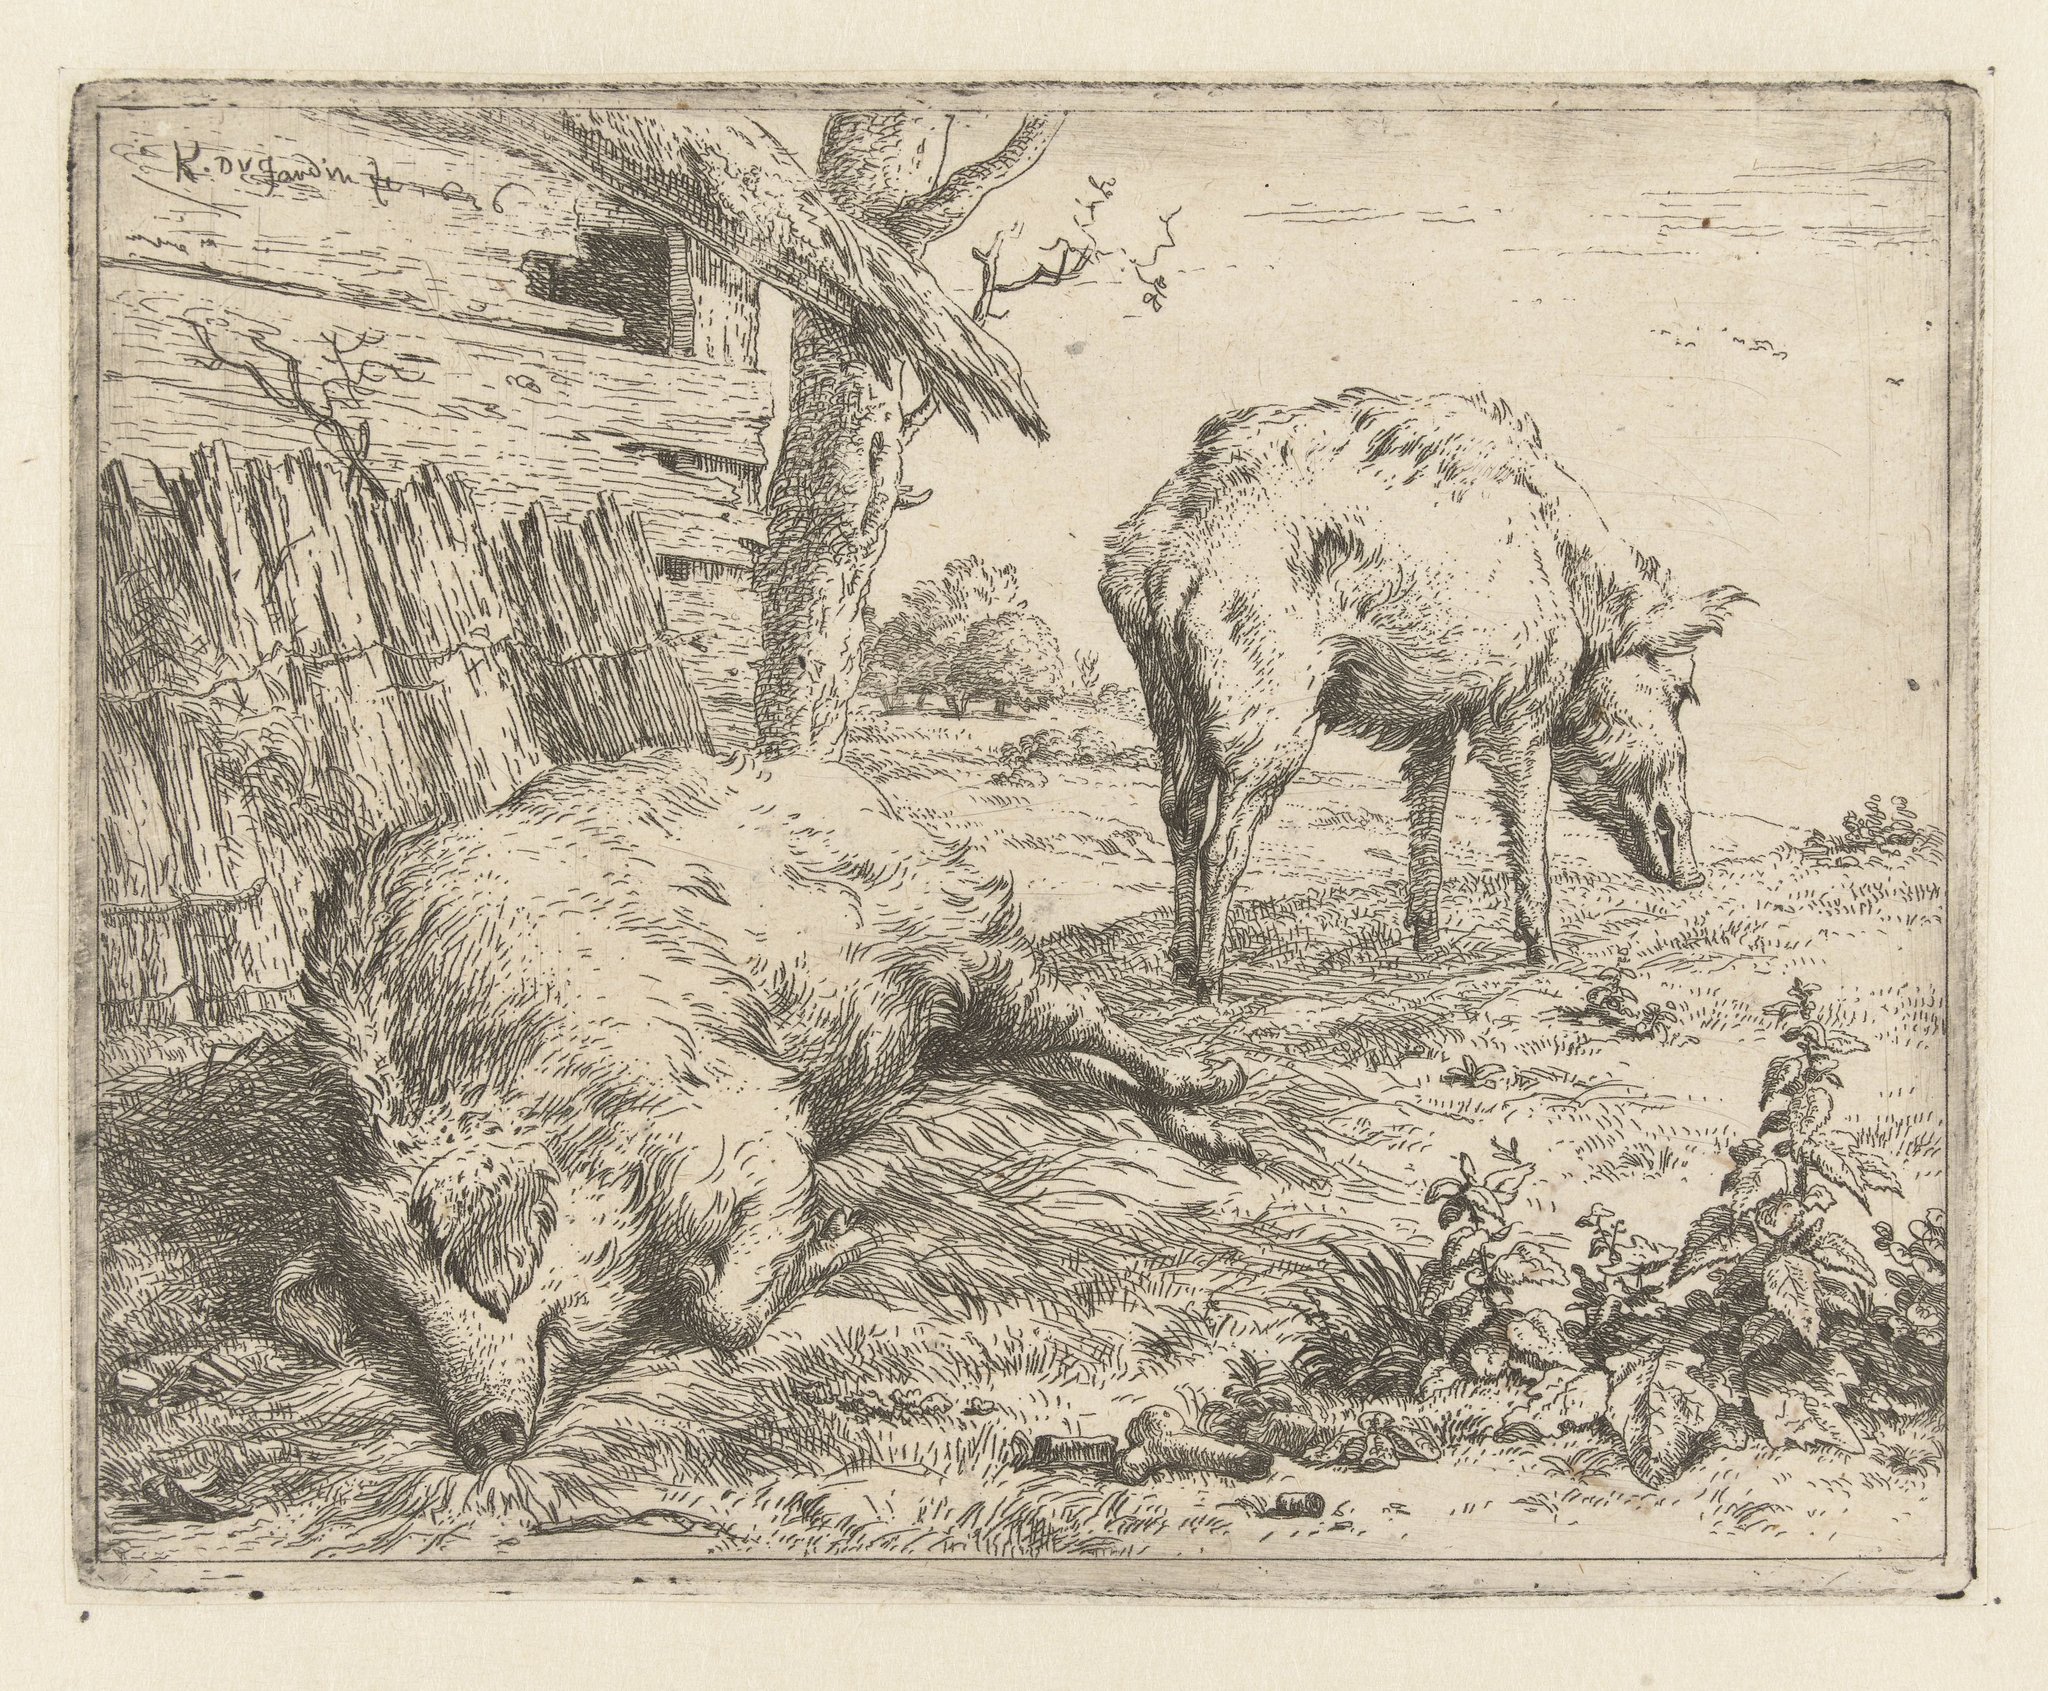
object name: print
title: Twee zwijnen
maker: karel du jardin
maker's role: draughtsman, painter, print maker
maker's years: 1626-1678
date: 1656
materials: paper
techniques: etching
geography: netherlands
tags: boar (male pig)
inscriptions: collector's mark: Lugt 240